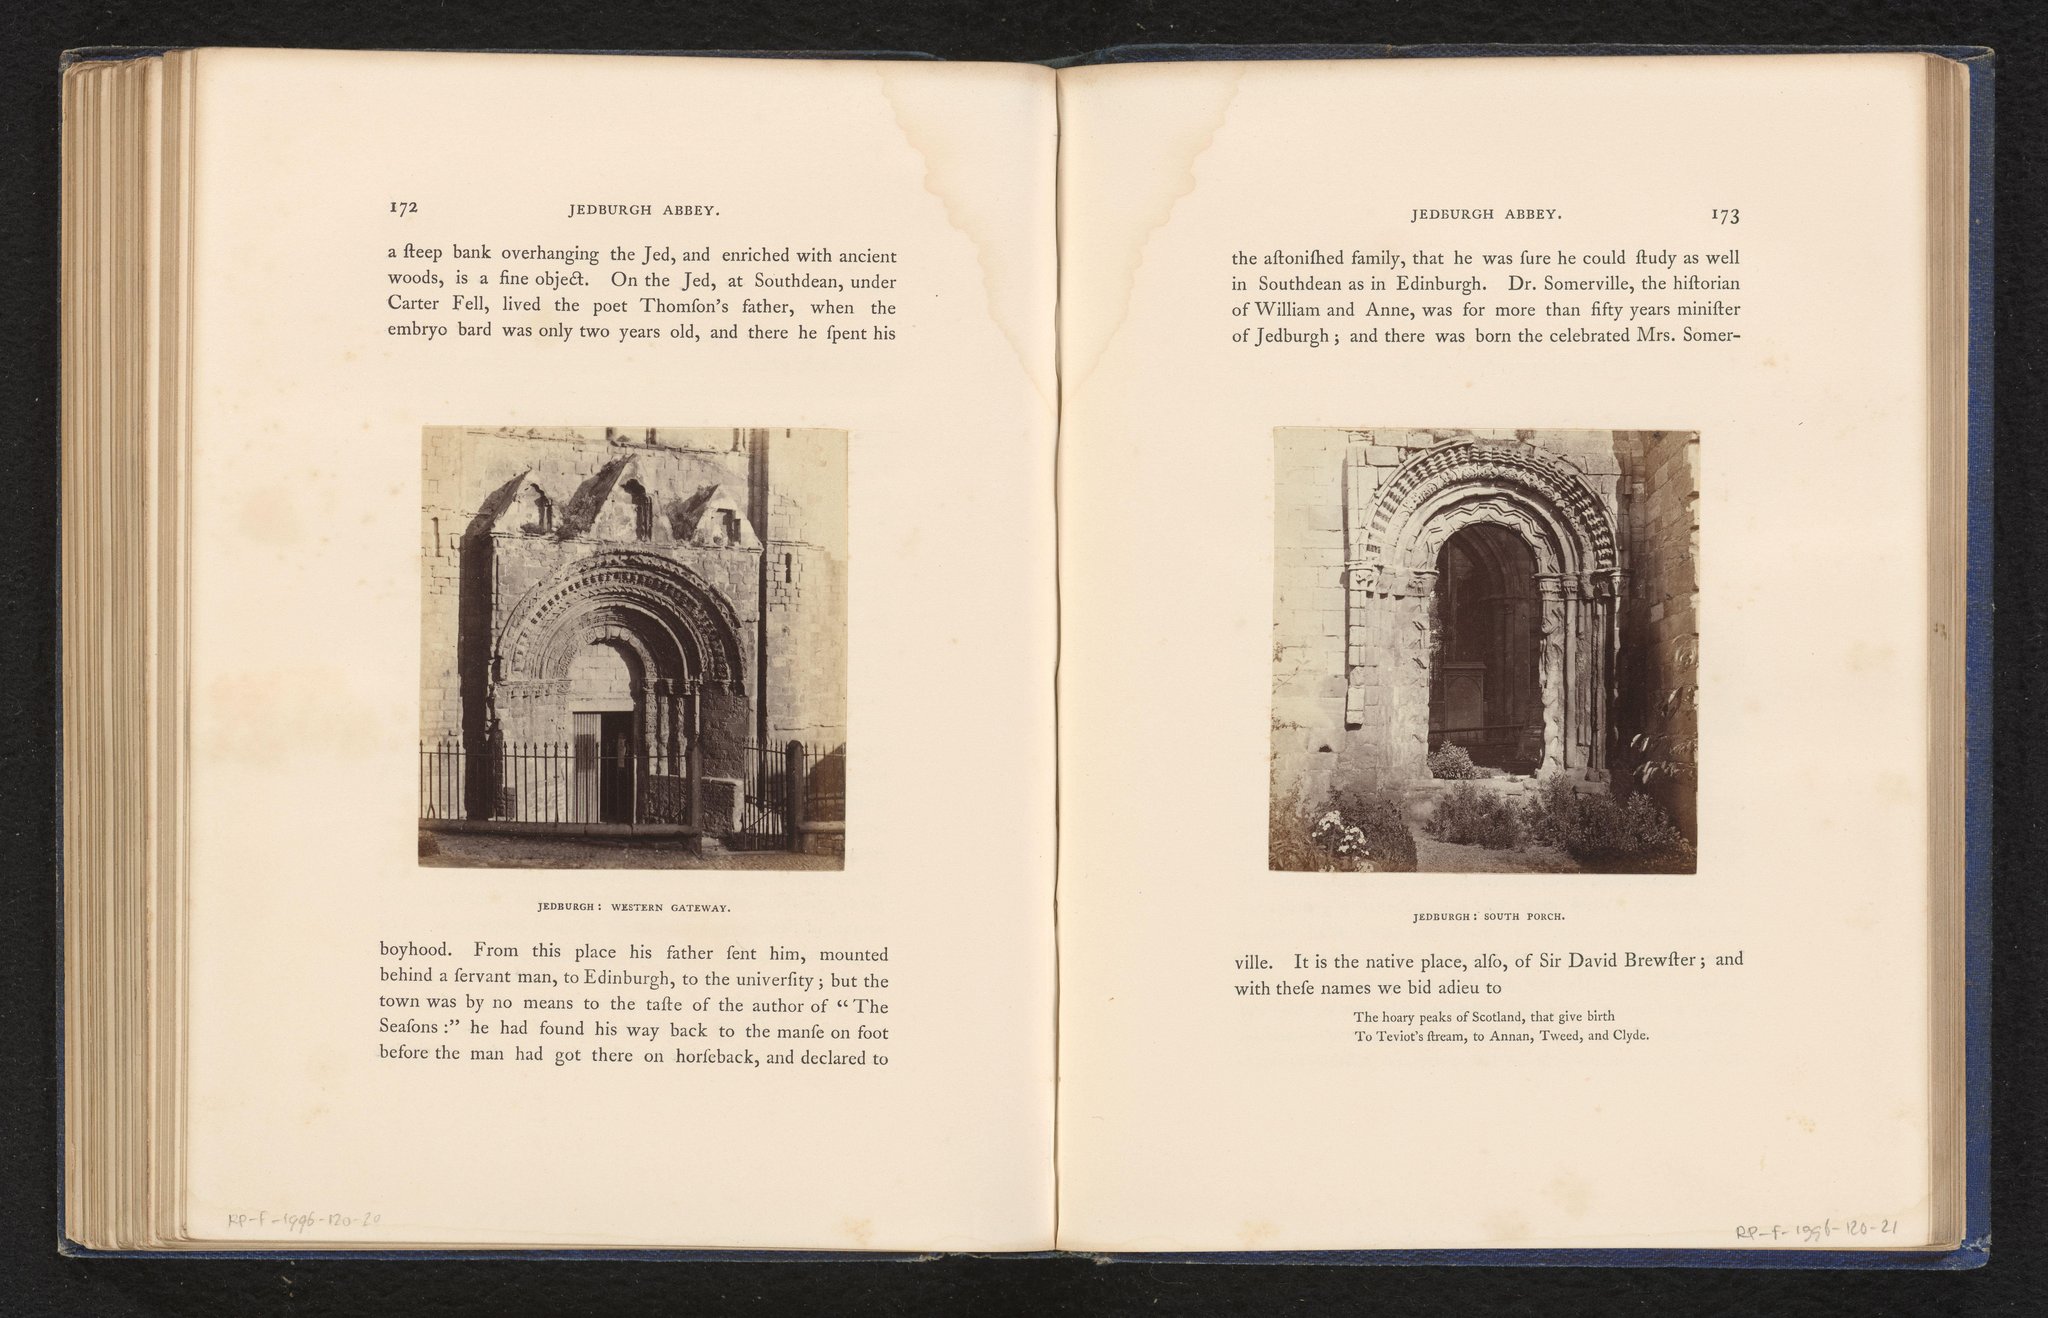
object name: page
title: Zuidelijk portaal van Jedburgh Abbey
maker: stephen thompson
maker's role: fotograaf, schrijver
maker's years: 1831-1893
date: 1859-1864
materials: paper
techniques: albumen print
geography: jedburgh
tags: parts of church exterior and annexes: portal